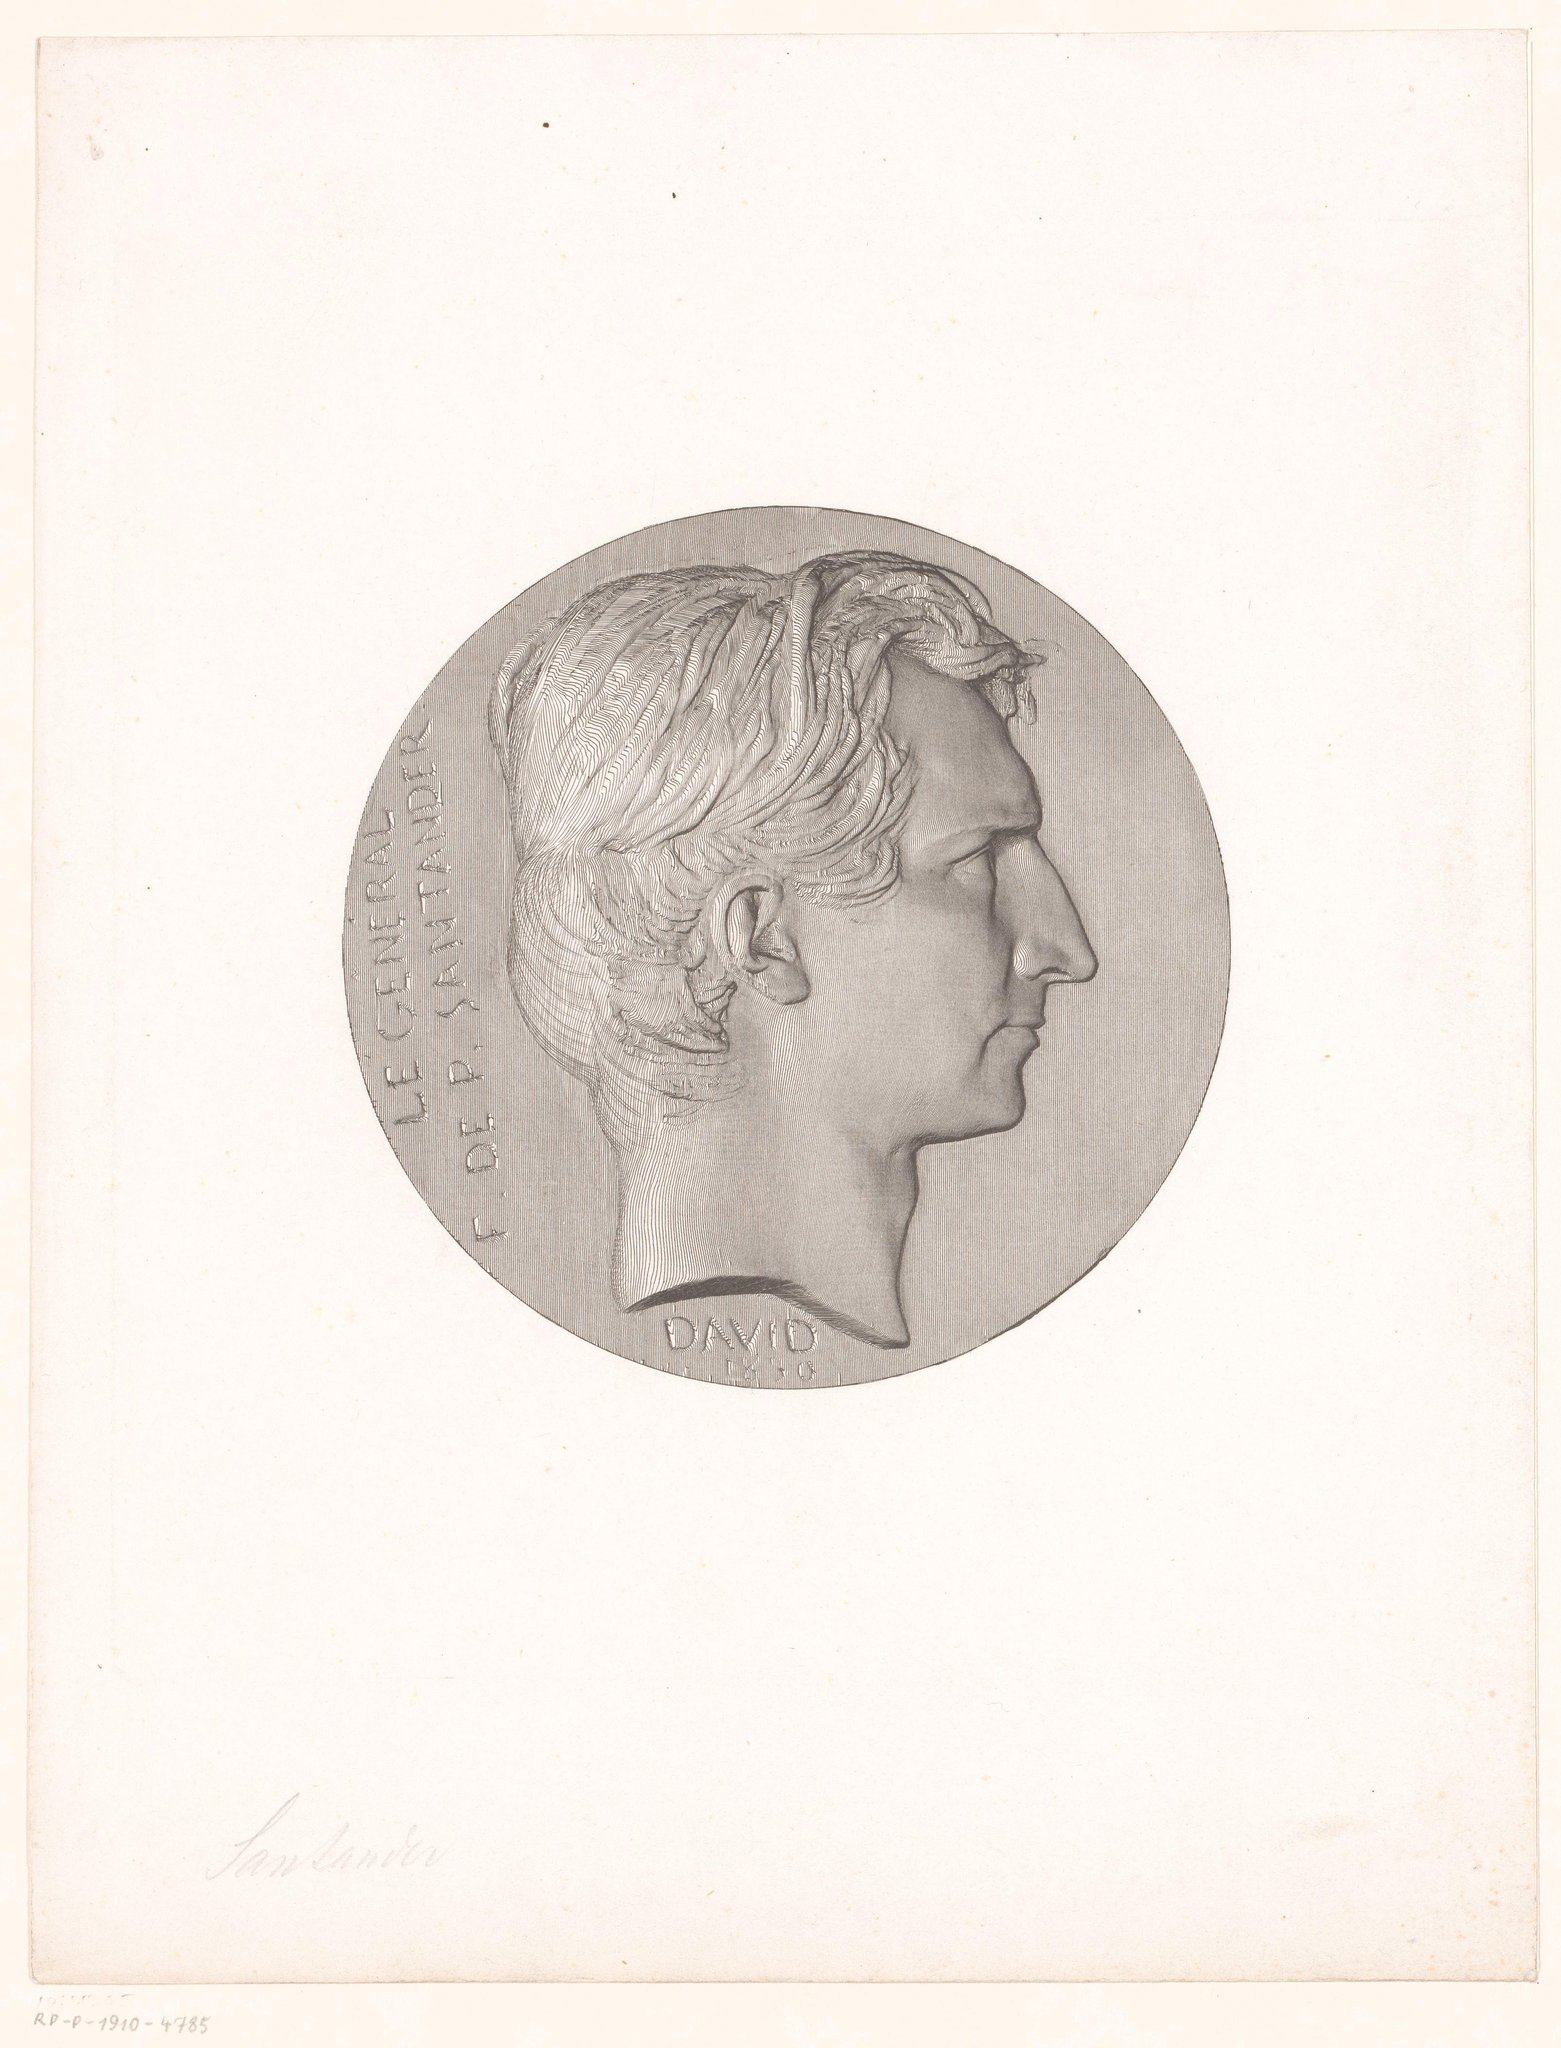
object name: print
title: Le general F. de P. Santander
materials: paper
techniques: relief engraving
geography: france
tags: ornament ~ medallion, historical persons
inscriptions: collector's mark: Lugt 2228